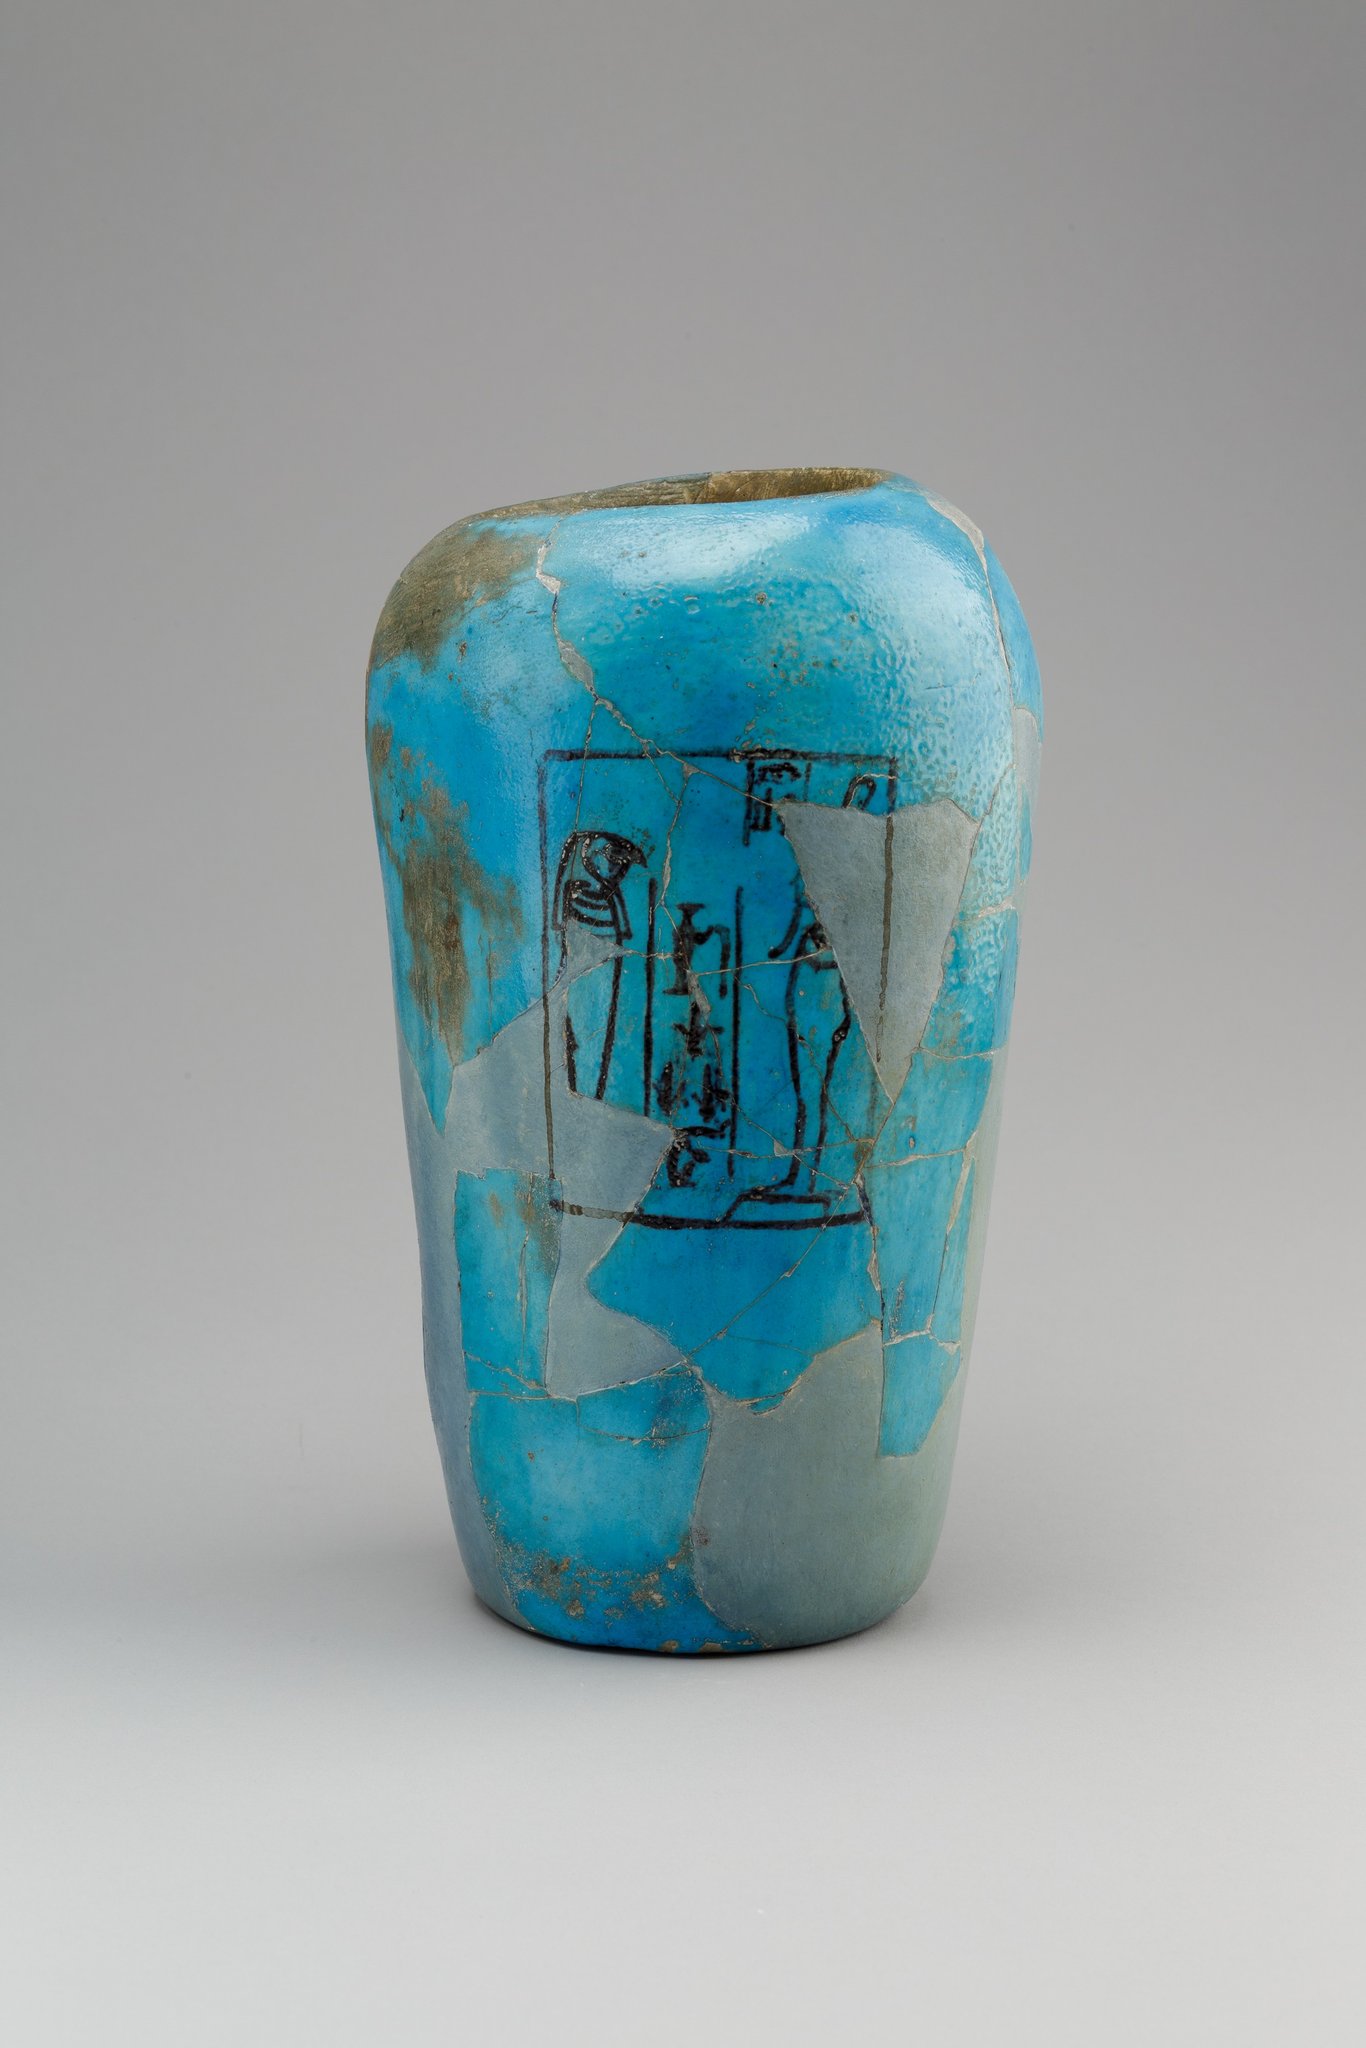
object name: canopic jar, qebehsenuef, osiris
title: Canopic Jar, Qebehsenuef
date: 712-332 BCE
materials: faience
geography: egypt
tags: hieroglyphs